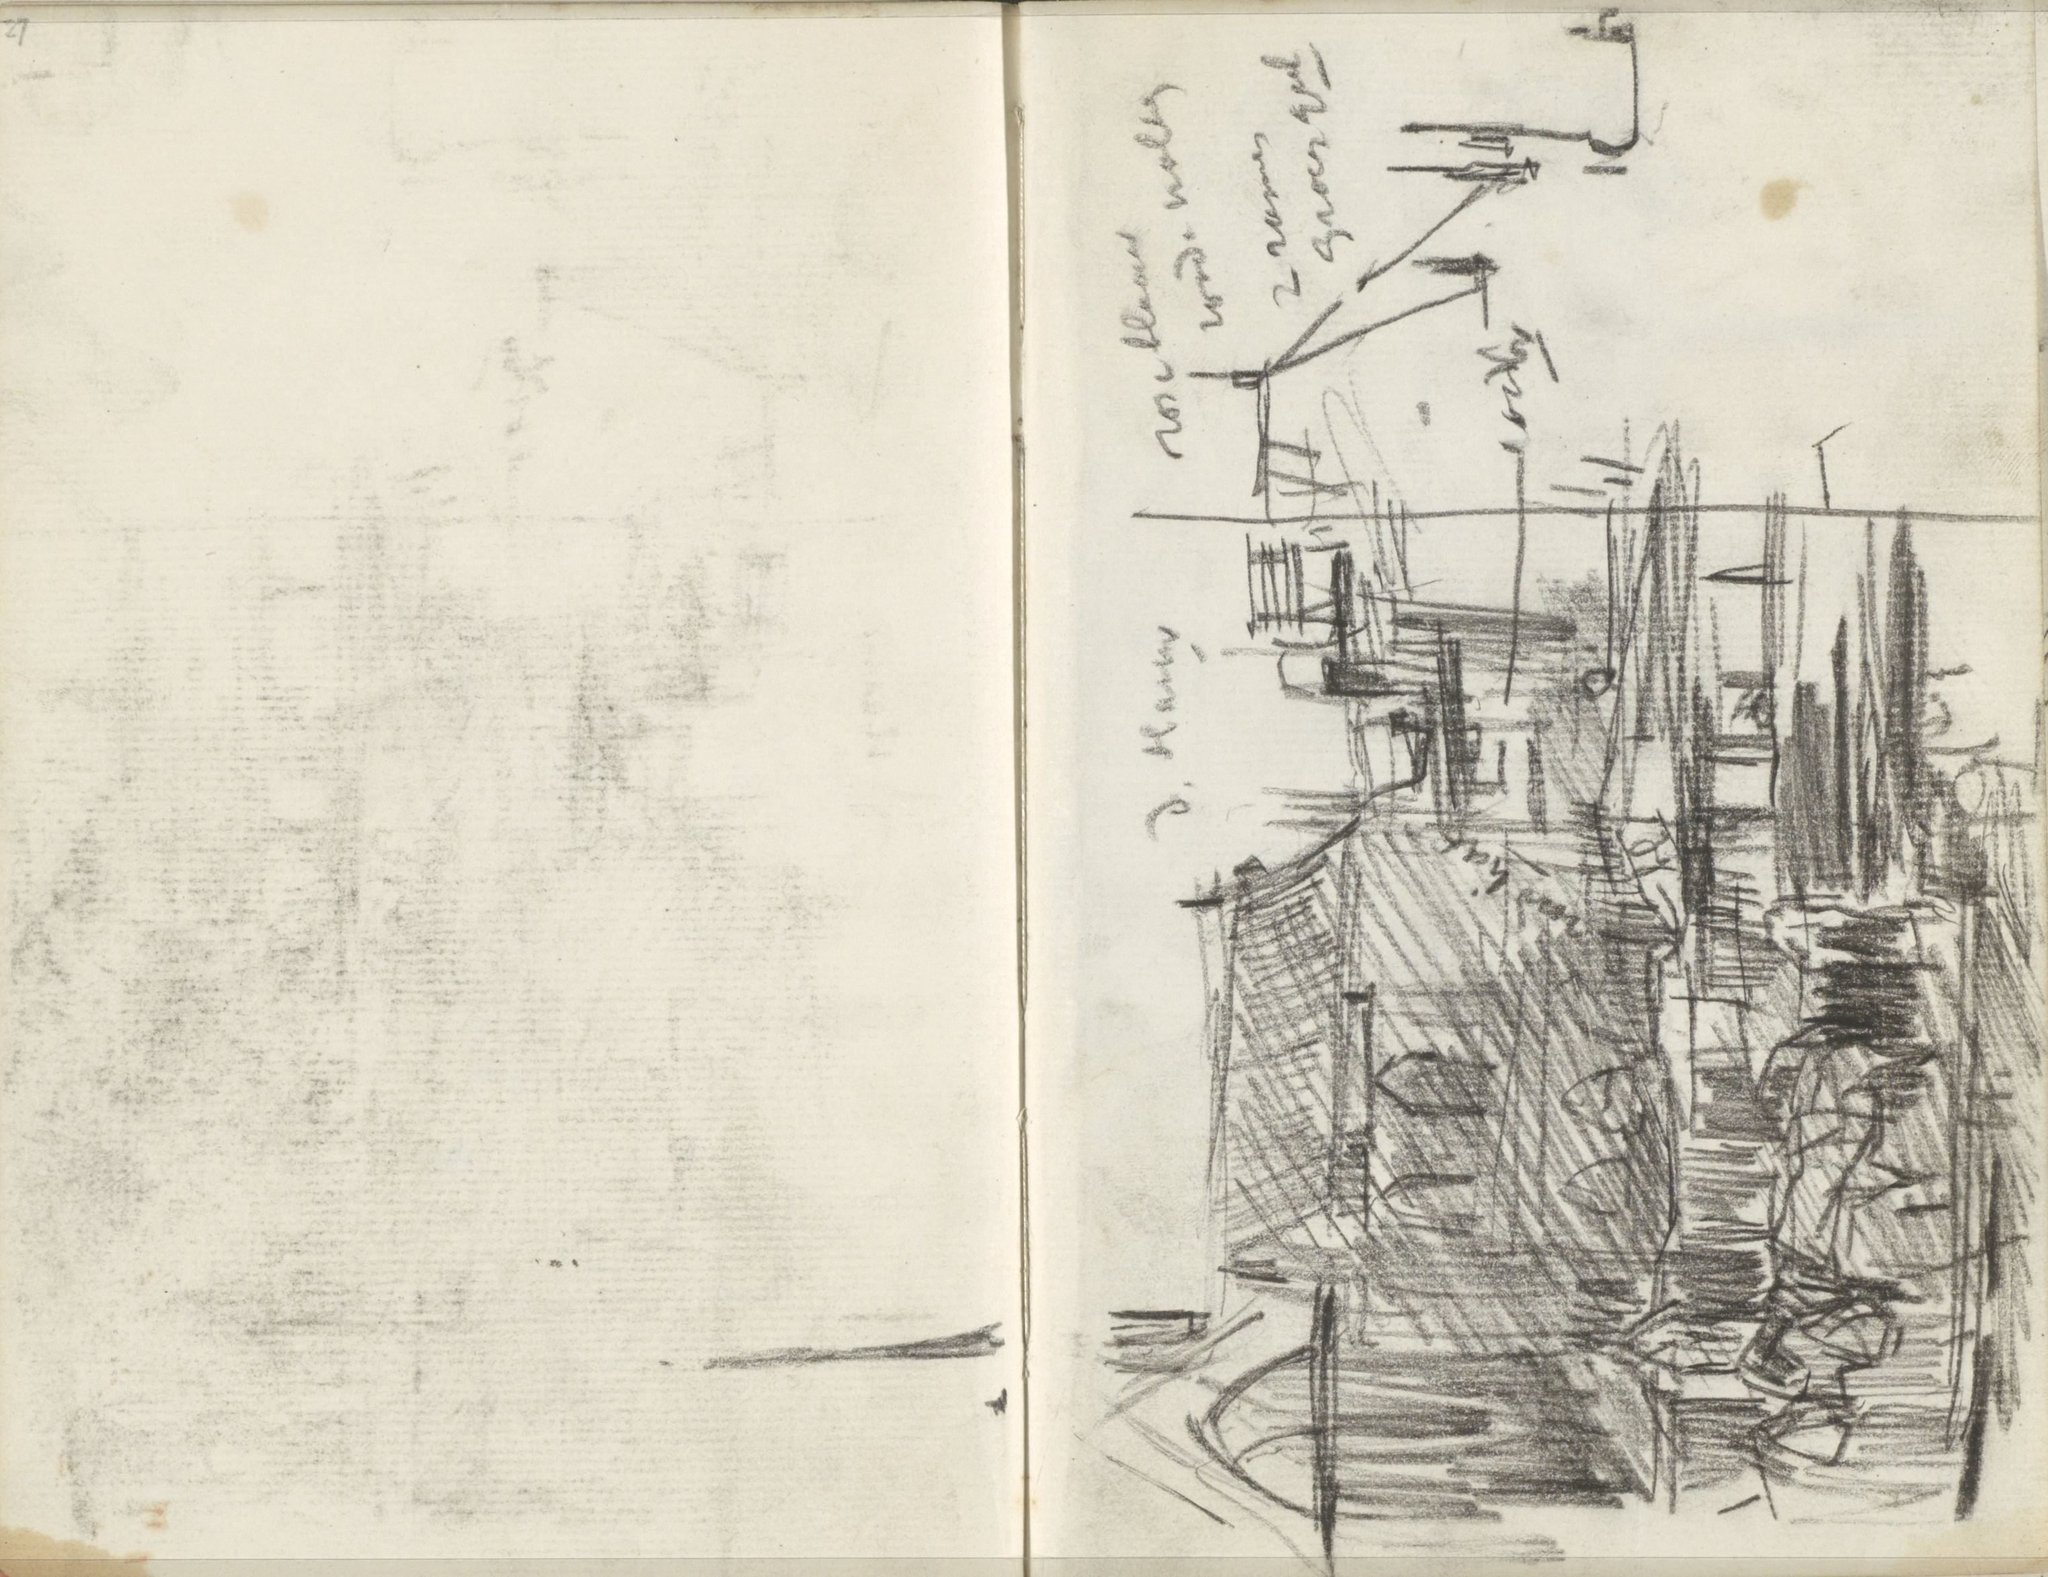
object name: sketchbook leaf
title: Gezicht op de Dam te Amsterdam met de Nieuwe Kerk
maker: george hendrik breitner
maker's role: draughtsman, painter, print maker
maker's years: 1857-1923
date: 1895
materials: chalk, paper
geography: amsterdam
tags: diligence, omnibus, horse-tram, church (exterior), square, place, circus, etc. (+ city(-scape) with figures, staffage)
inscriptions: kleurnotitie, handgeschreven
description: Vooraan een paardentram. Pagina 27 en pagina 28 uit een schetsboek met 20 bladen.